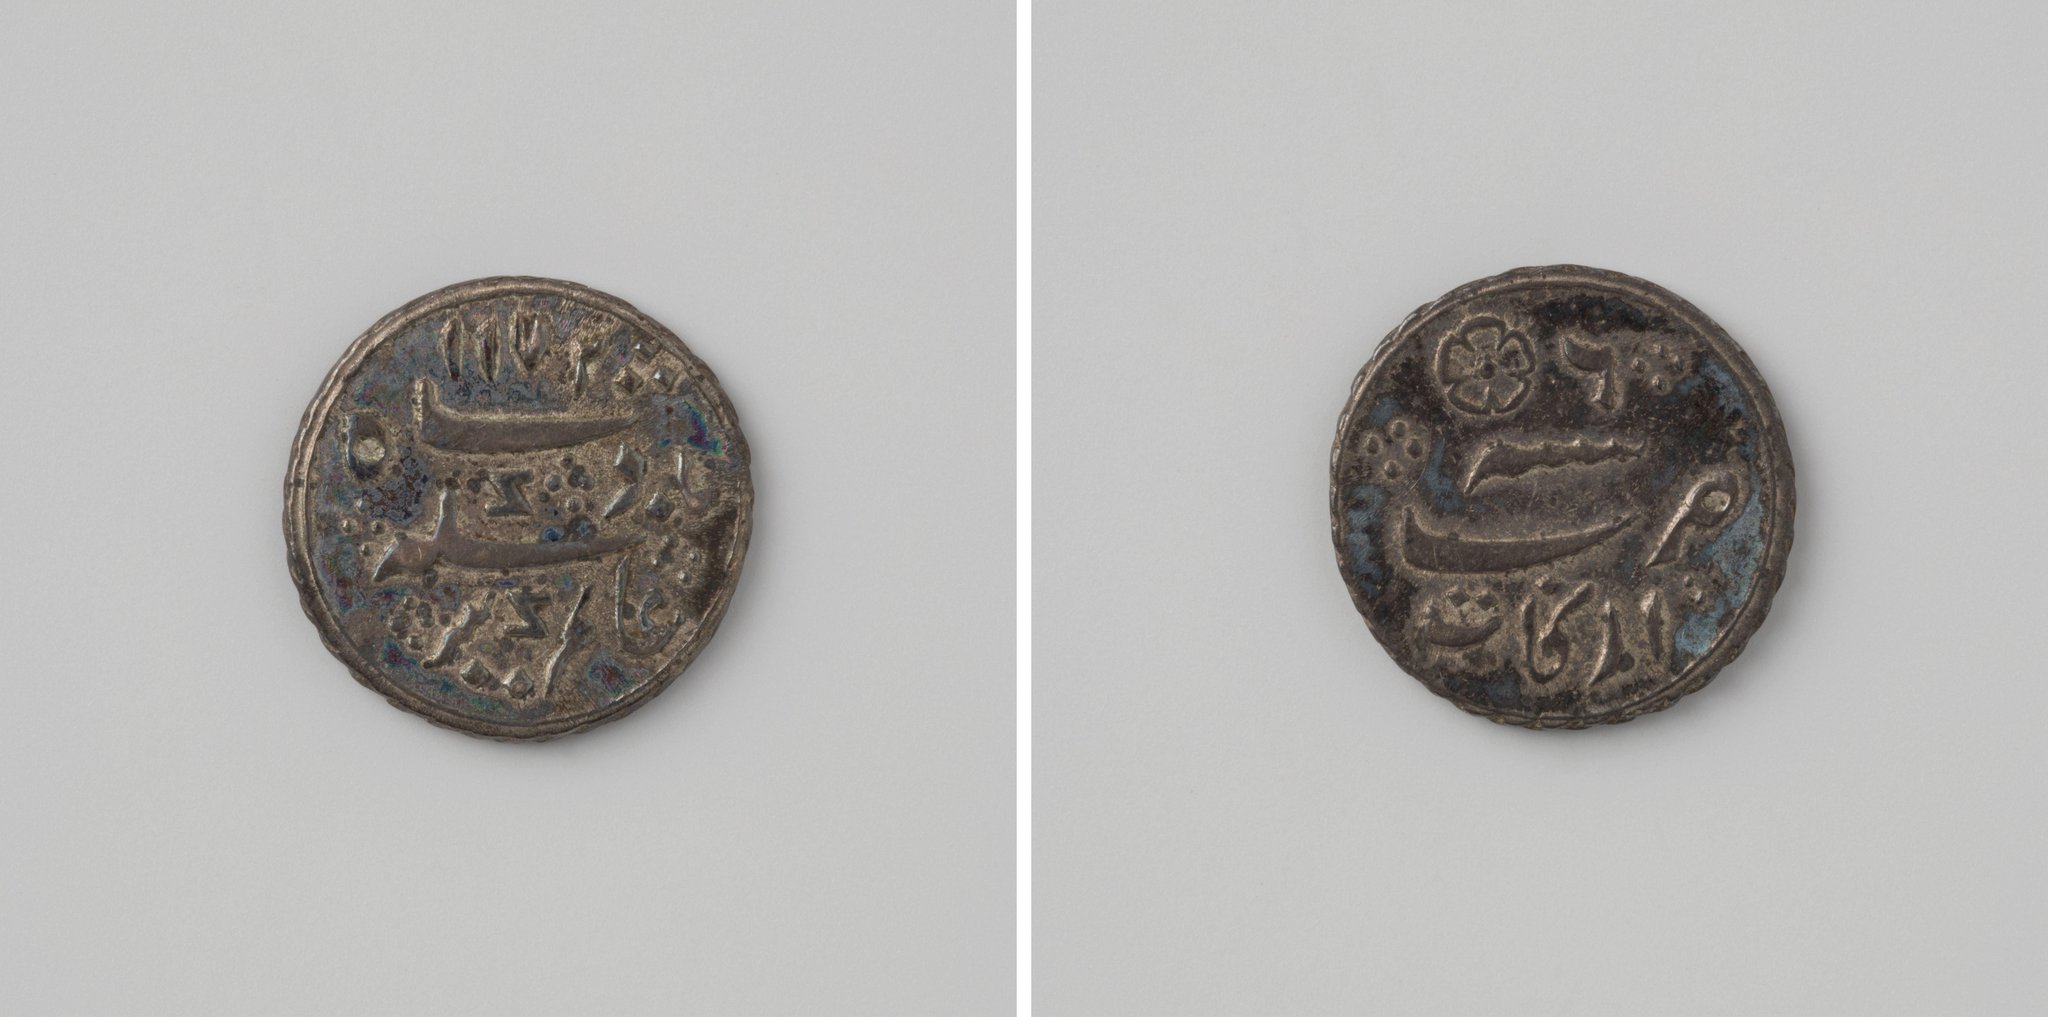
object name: coin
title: India, Engelse Oostindische Compagnie (EIC) , 1/16 arcot-roepie voor Madras, India, op naam van shah Alamgir II, (1823-1825)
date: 1823-1825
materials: silver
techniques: striking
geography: kolkata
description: Zilveren munt. Voorzijde: opschrift in drie regels in Arabische lettertekens, waarin verwijzing naar shah Alamgir II. Bovenaan "bevroren" jaartal: 1172. Keerzijde: opschrift in drie regels in Arabische lettertekens. Bovenaan links rozet [=muntplaats Calcutta]. Kabelrand.